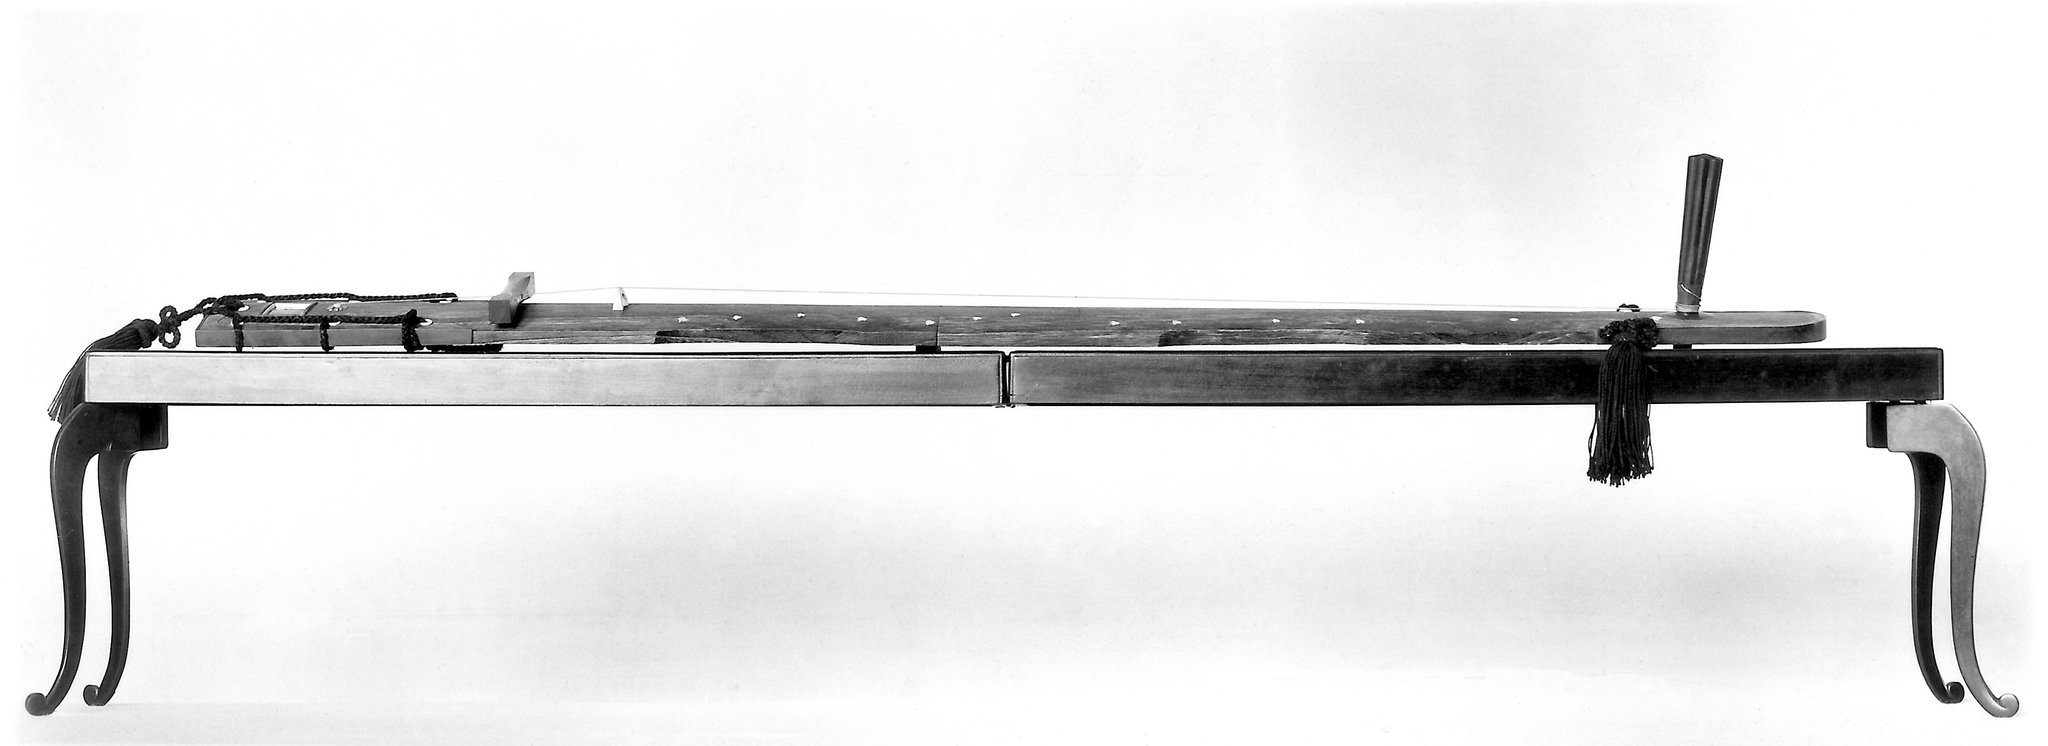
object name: ichigen kin 一絃琴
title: Ichigen-kin (一絃琴)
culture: japanese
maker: kasuke satake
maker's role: maker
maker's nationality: japanese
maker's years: 1800-1900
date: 1801-1900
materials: coral, ivory, shell, wood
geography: japan